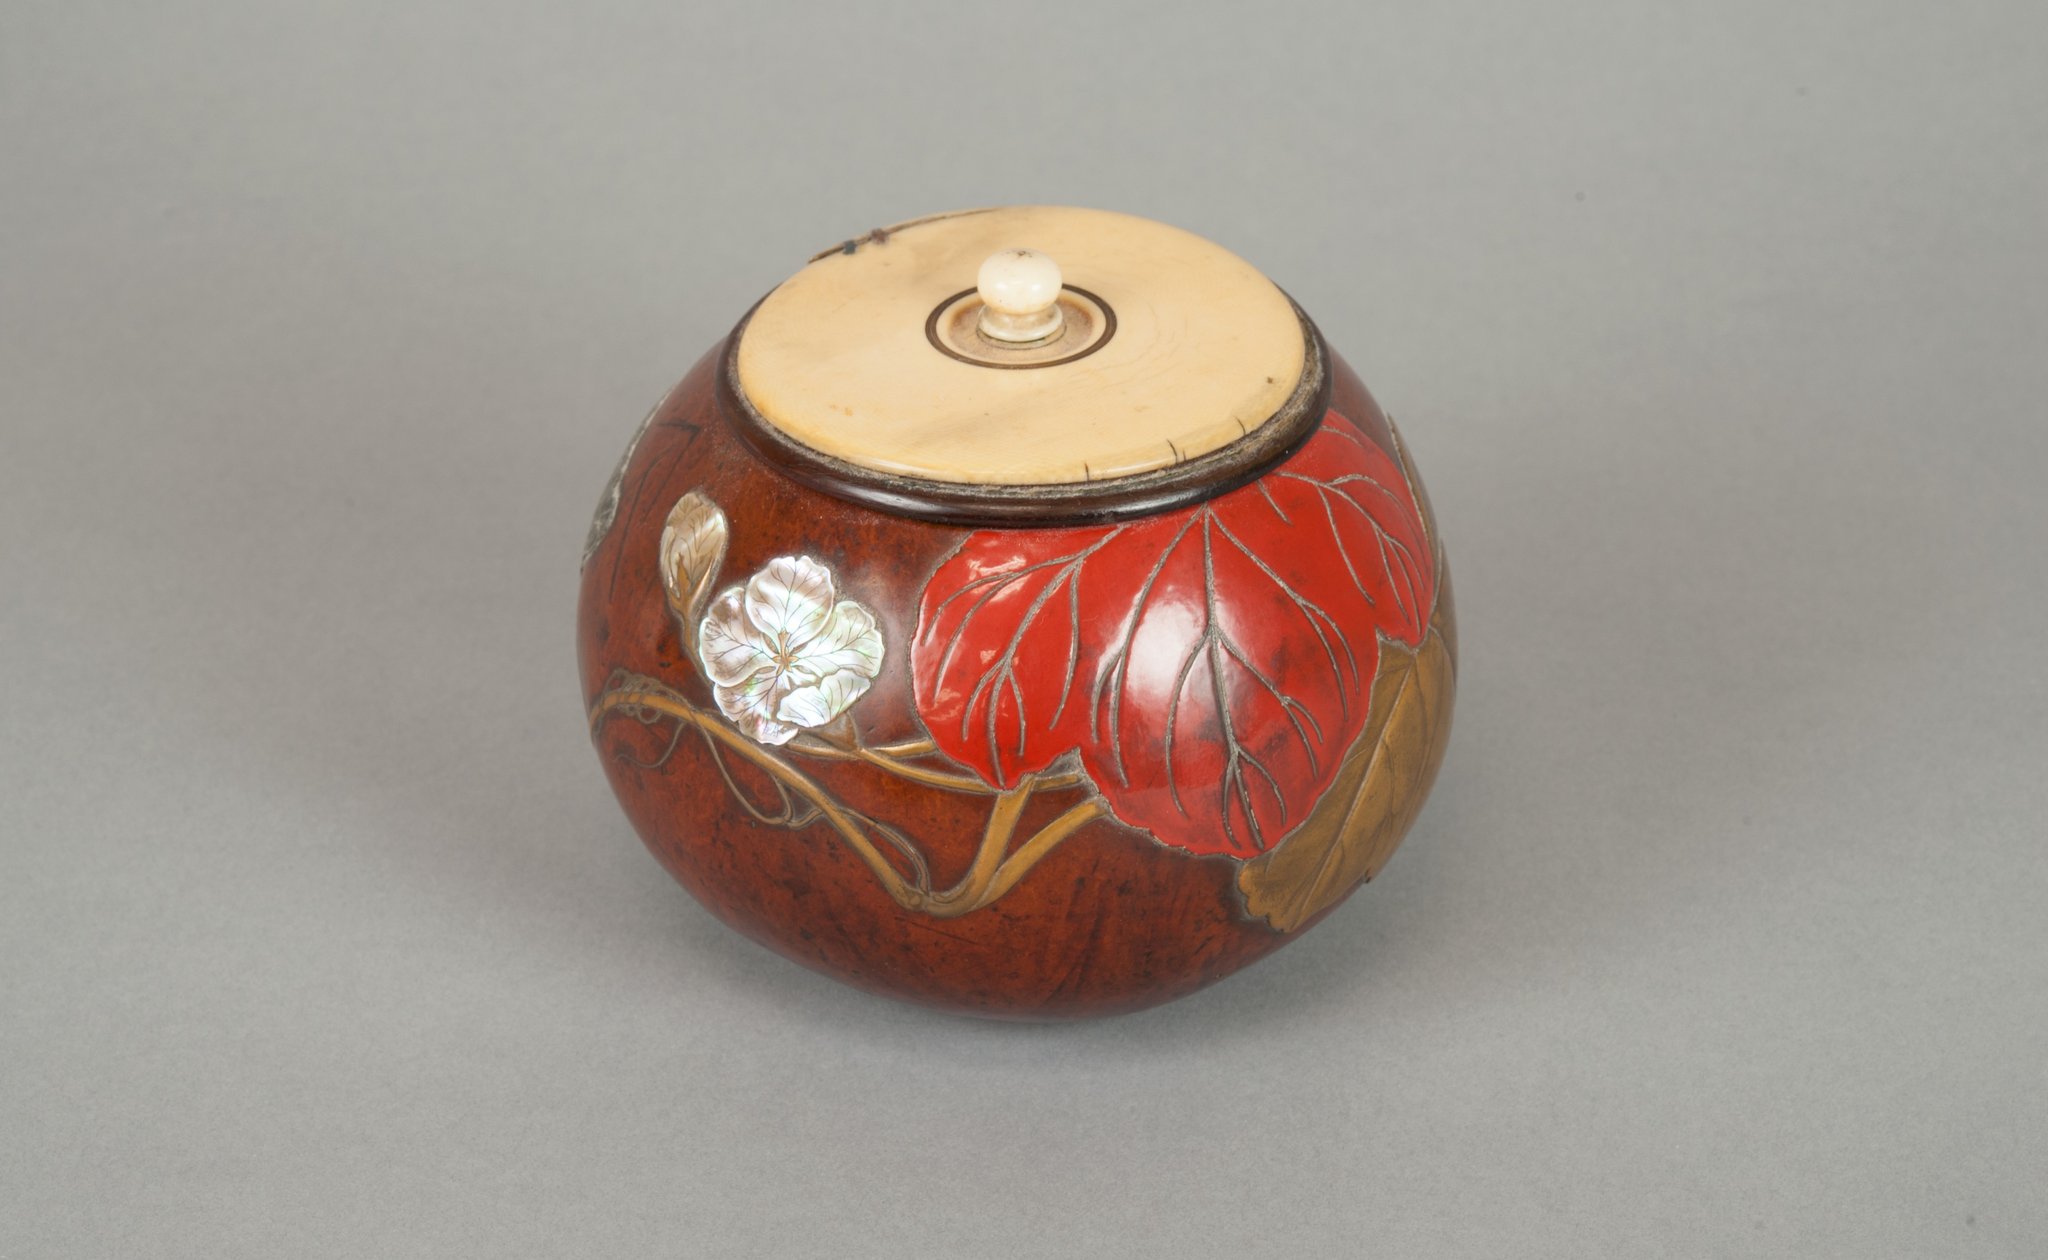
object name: box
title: Box with Design of “Evening Face” (Yūgao) Flowers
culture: japanese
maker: ogawa haritsu (ritsuō)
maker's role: artist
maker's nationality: japanese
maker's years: 1663-1747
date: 1851-1900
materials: ceramic, gold, mother of pearl, tin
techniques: inlay, maki-e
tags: flowers,leaves